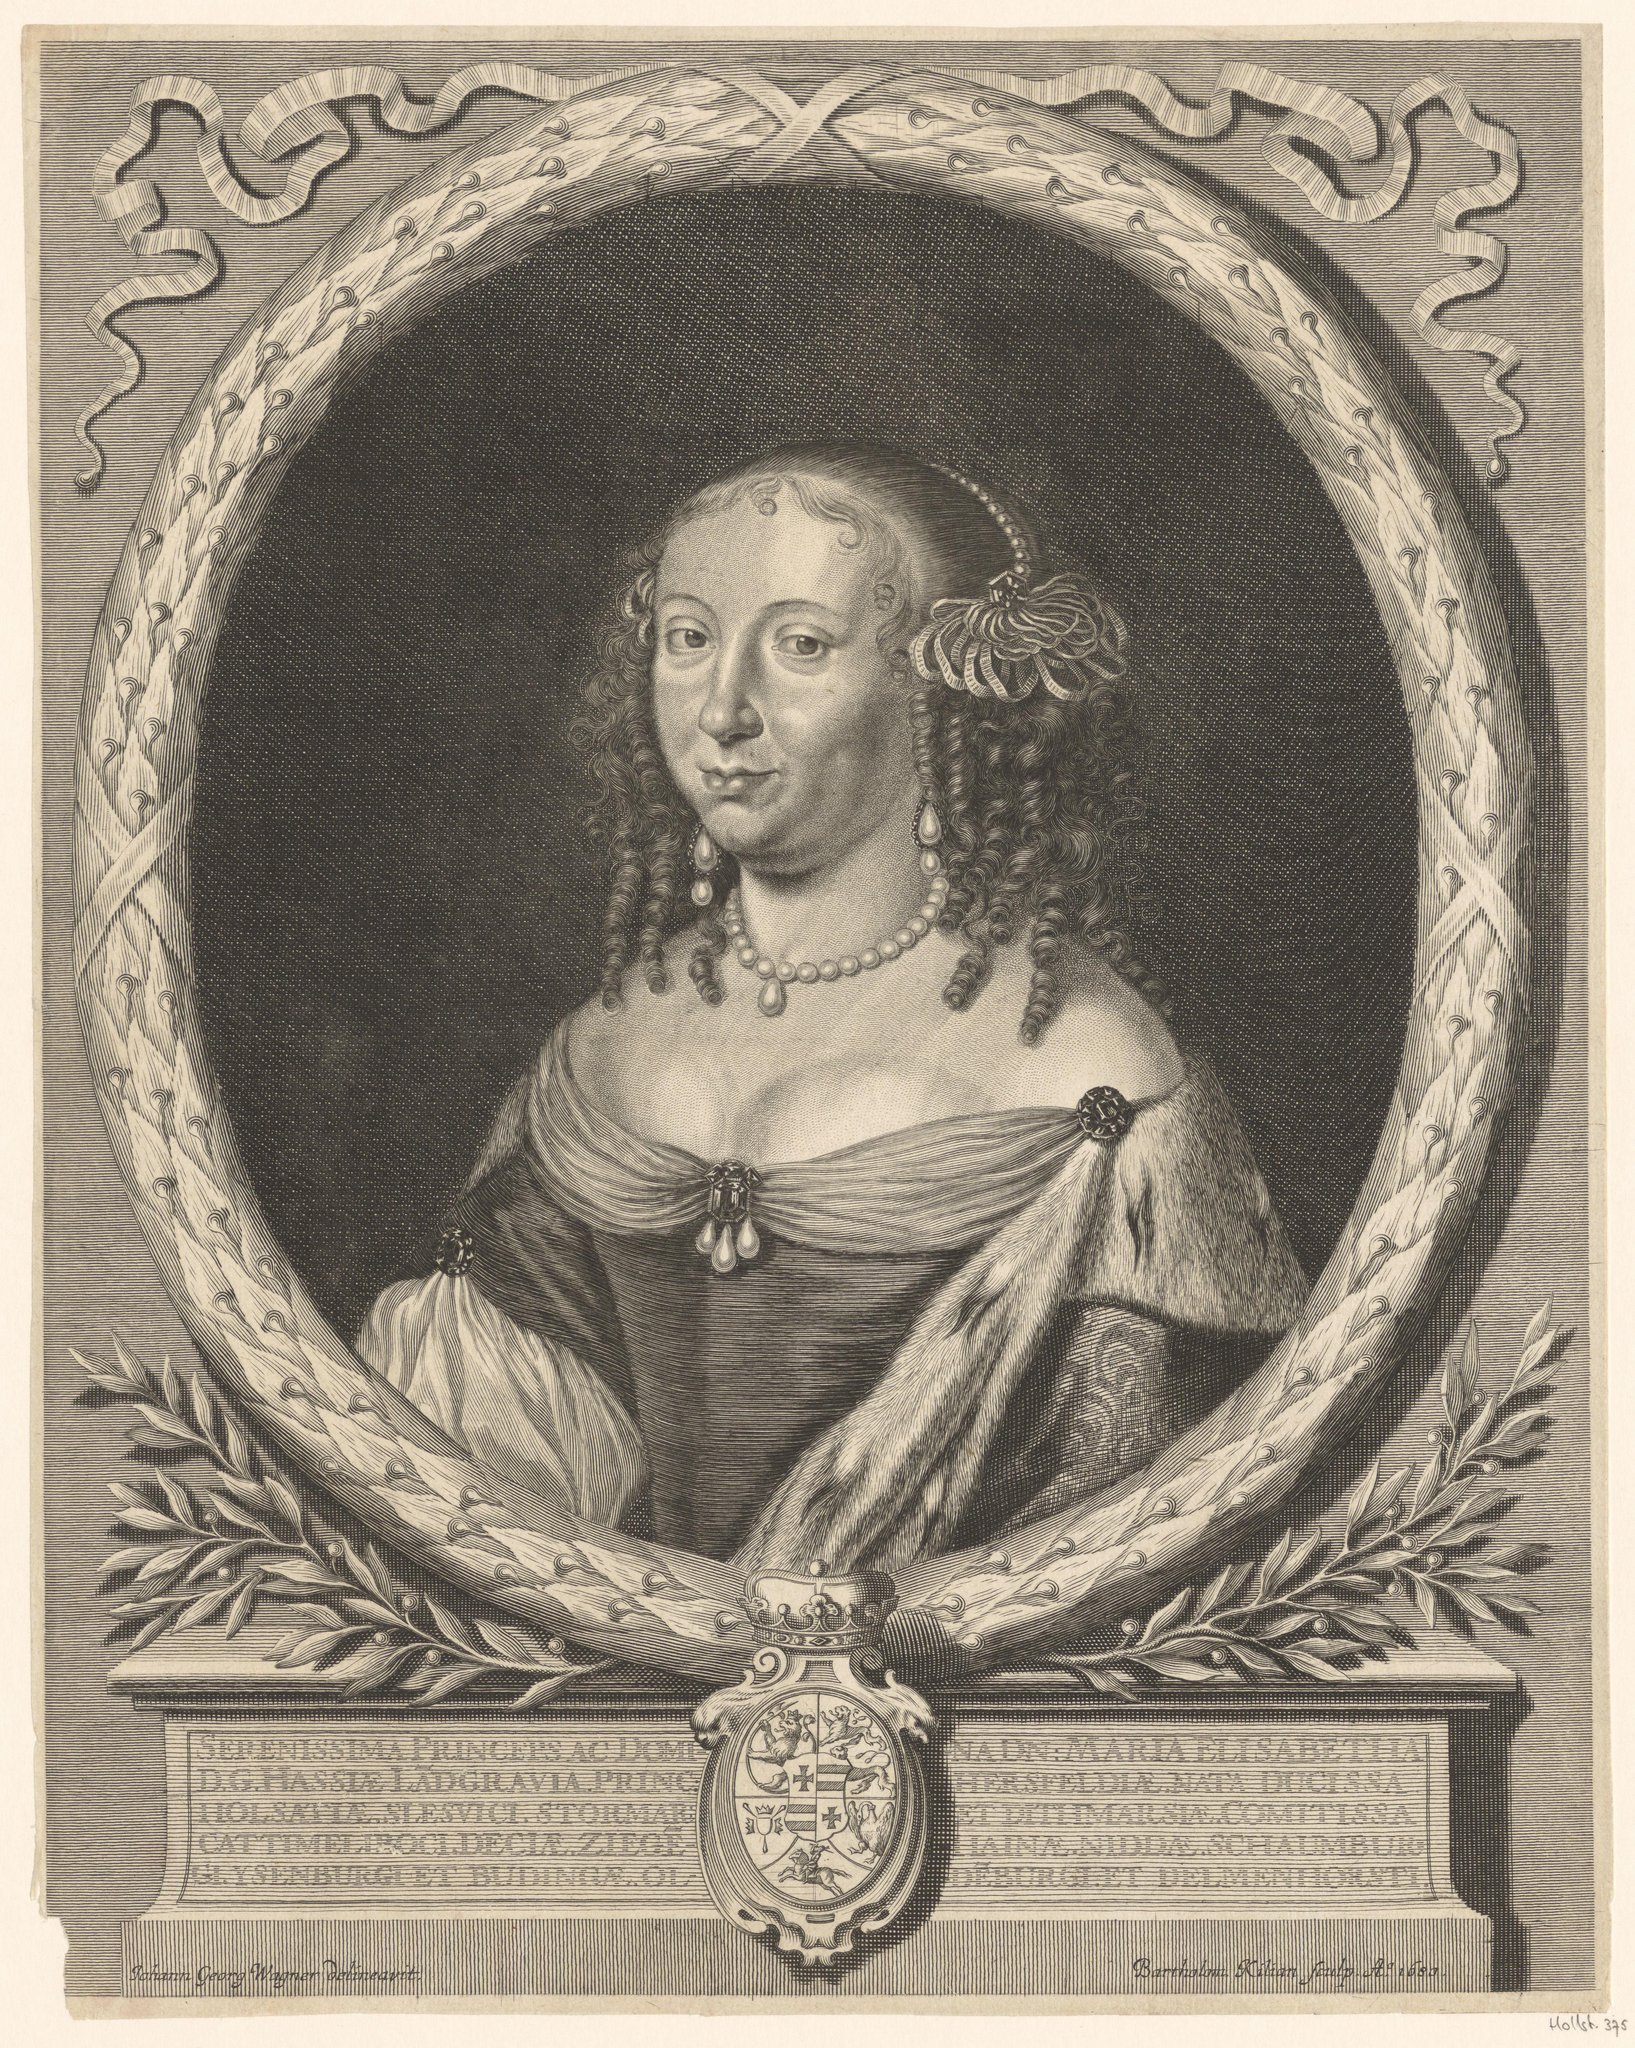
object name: print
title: Portret van Maria Elisabeth Hessen-Darmstadt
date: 1680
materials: paper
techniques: engraving, etching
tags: historical persons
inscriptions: collector's mark: Lugt 240